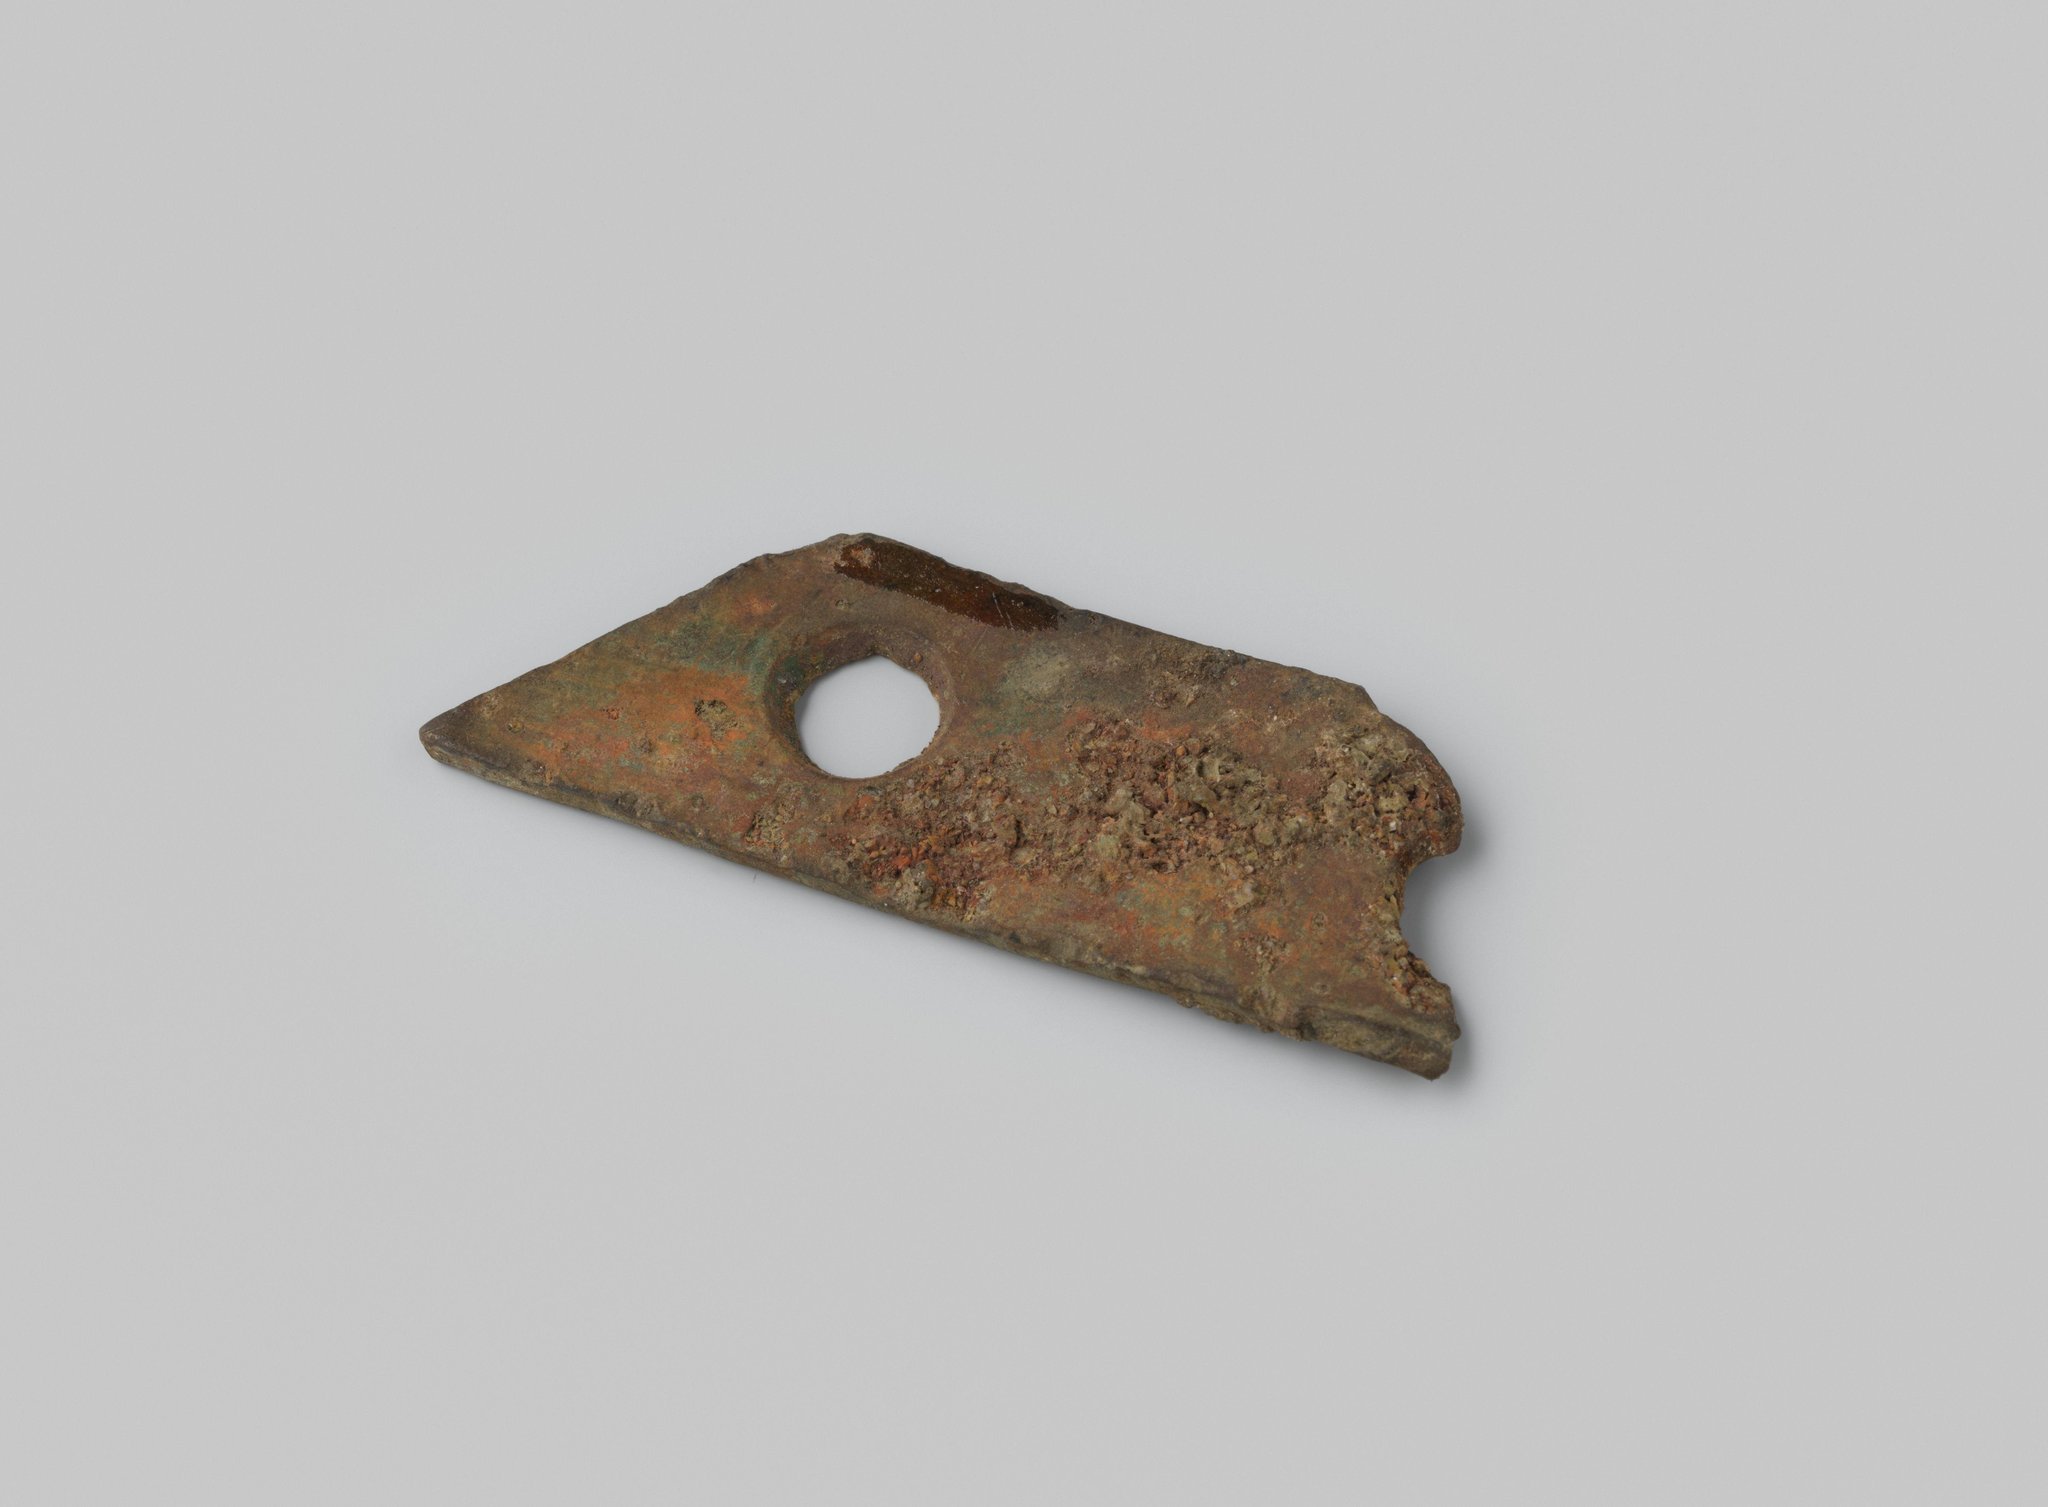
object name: part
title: Onderdeel of hulpstuk afkomstig uit het wrak van de Oost-Indiëvaarder Hollandia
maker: Anonymous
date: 1700-1743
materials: copper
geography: netherlands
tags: verenigde oostindische compagnie, hollandia (schip)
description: Strip-shaped fitting; fragm, id. 80H1737.